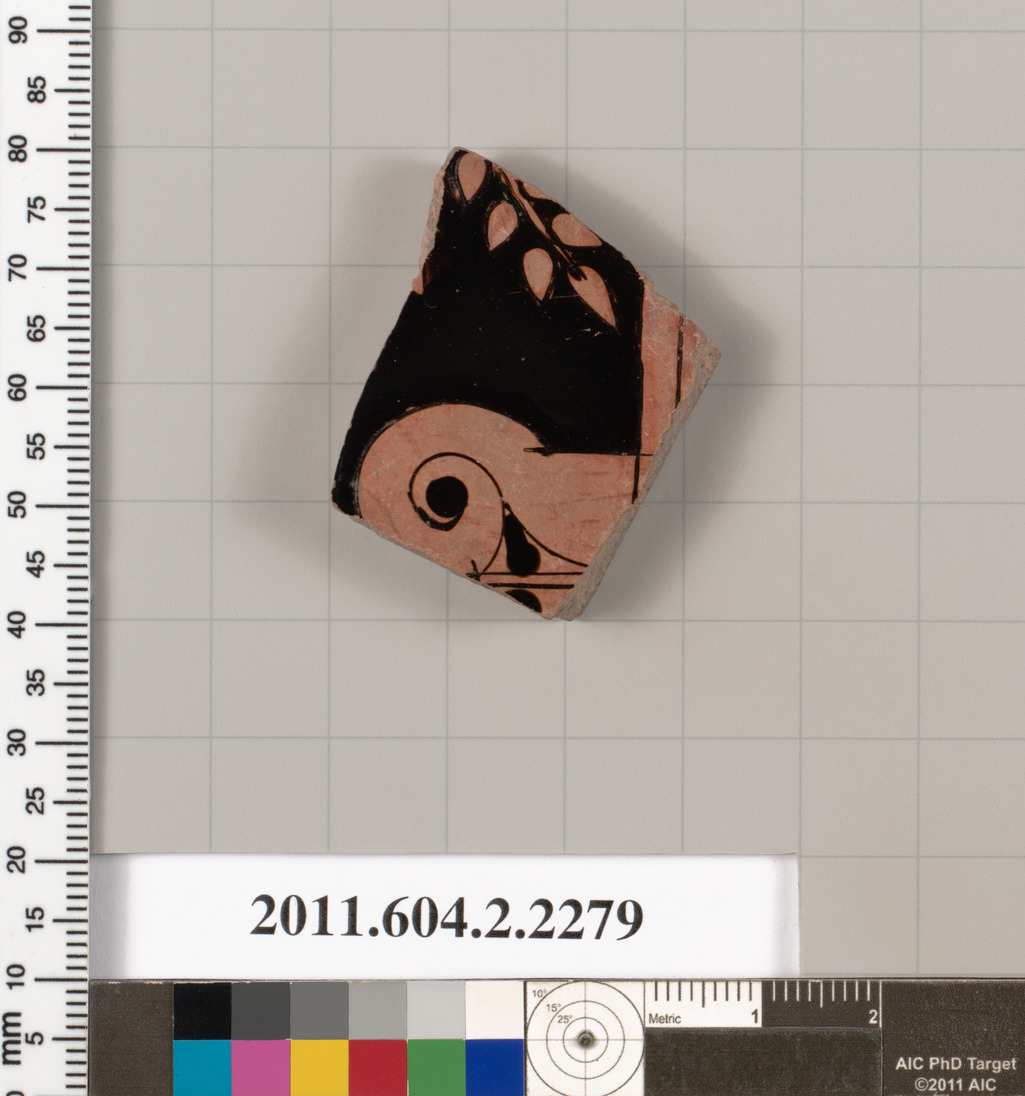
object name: column krater fragment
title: Terracotta fragment of a column-krater (bowl for mixing wine and water)?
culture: greek, attic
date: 480-470 BCE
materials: terracotta